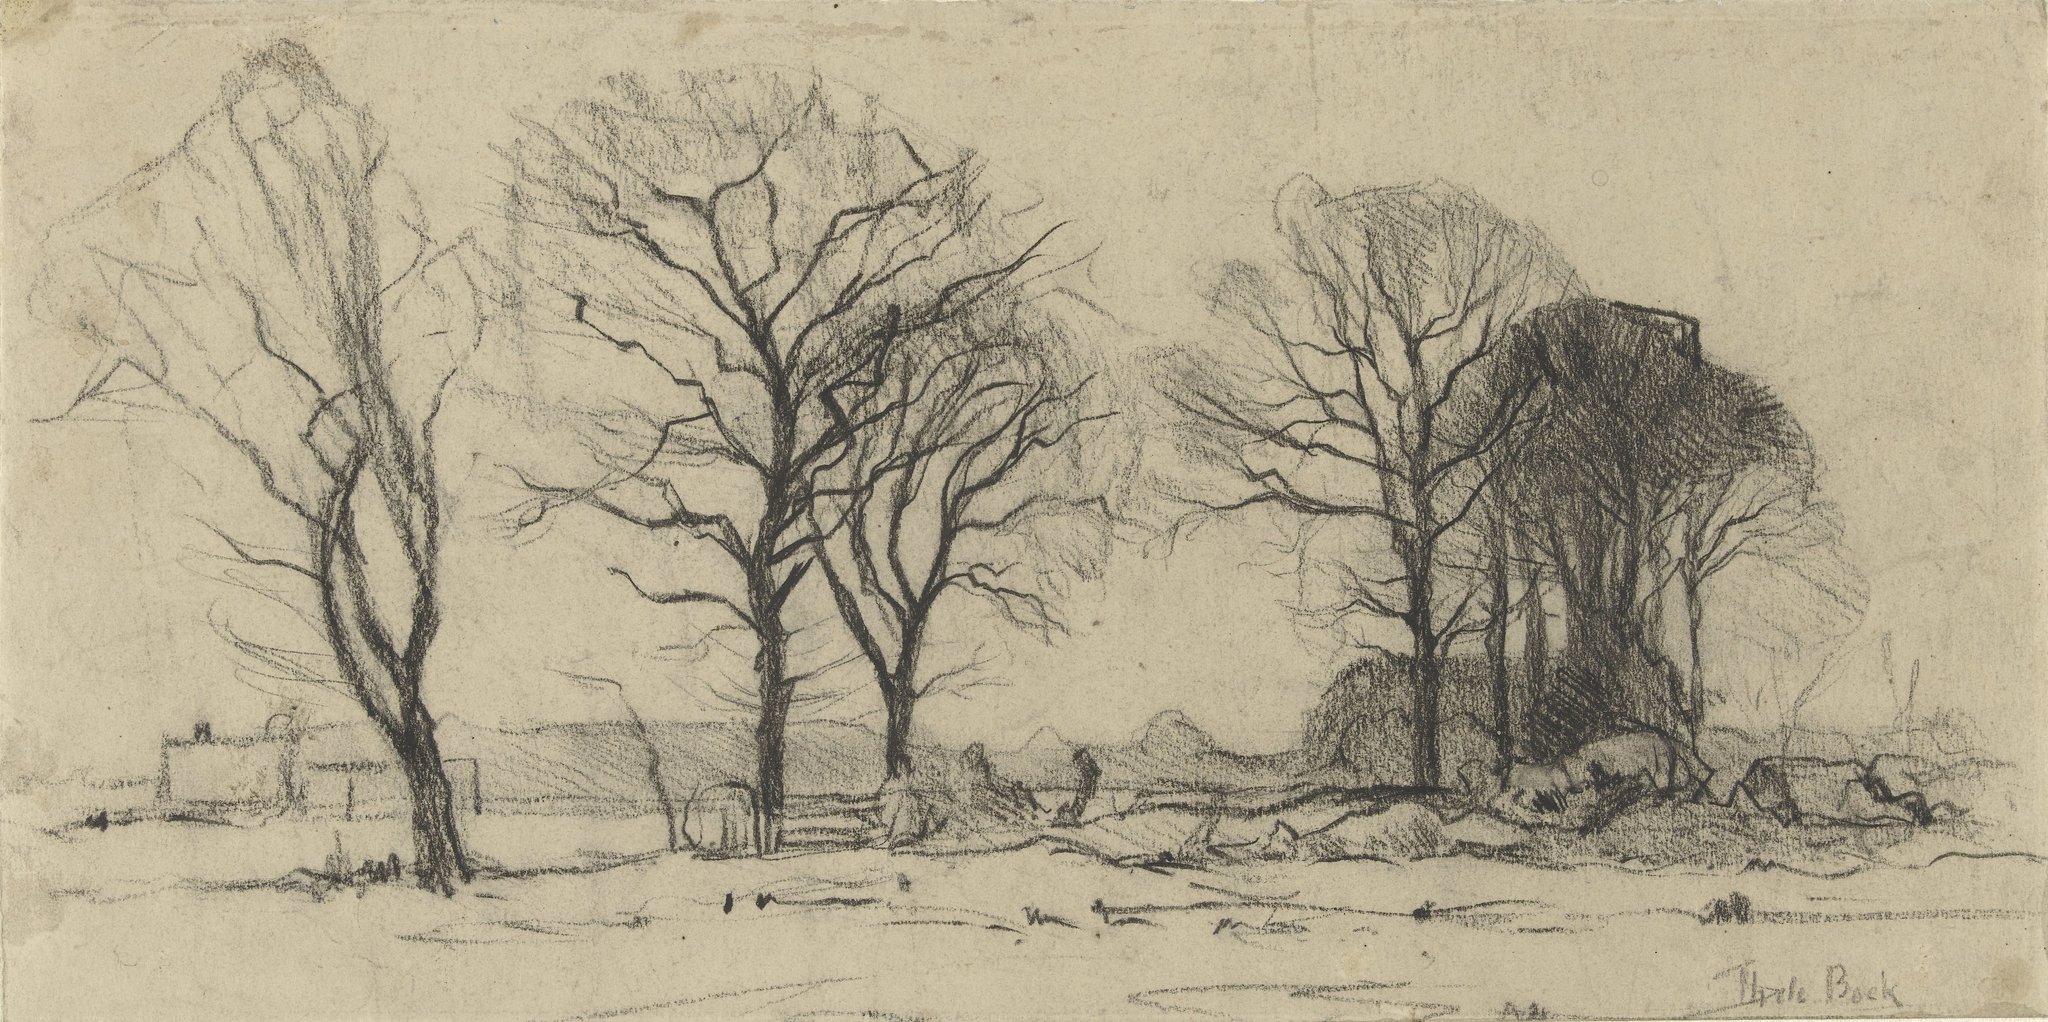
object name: drawing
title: Landschap met bomen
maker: théophile de bock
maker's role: draughtsman, painter, print maker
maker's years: 1851-1904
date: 1861-1904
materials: chalk, paper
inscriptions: inscription: ‘.’